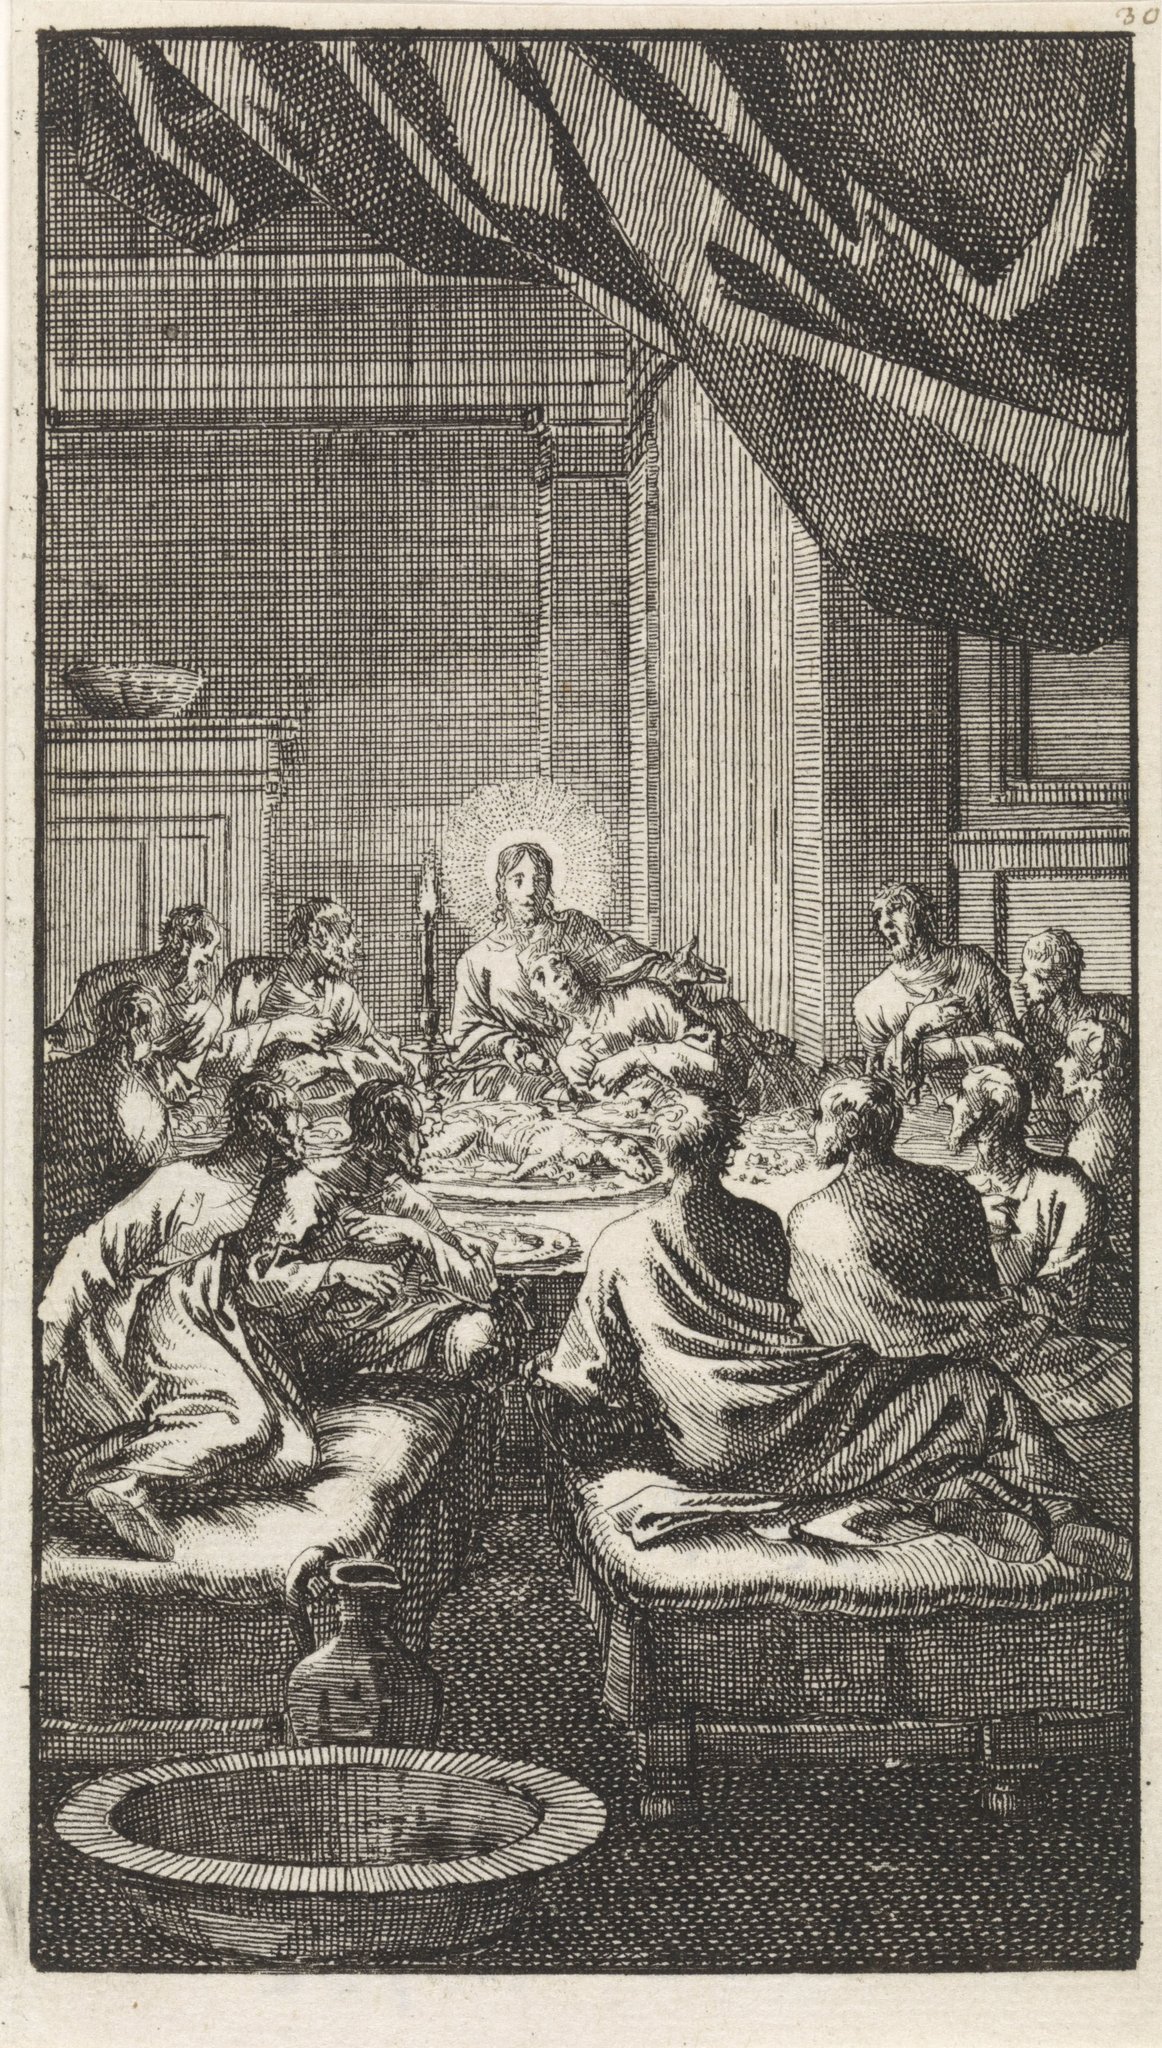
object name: print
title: Laatste Avondmaal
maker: jan luyken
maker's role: draughtsman, print maker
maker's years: 1649-1712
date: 1712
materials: paper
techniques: etching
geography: amsterdam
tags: last supper (in general) (matthew 26:21-35; mark 14:18-31; luke 22:3, 22:15-23; john 13:21-38)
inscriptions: collector's mark: Lugt 2228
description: Proefdruk van illustratie voor: Luyken, Jan. Bybel printen. Amsterdam: Pieter Arentsz. II (wed.) en Cornelis van der Sys, 1712, p. 24.